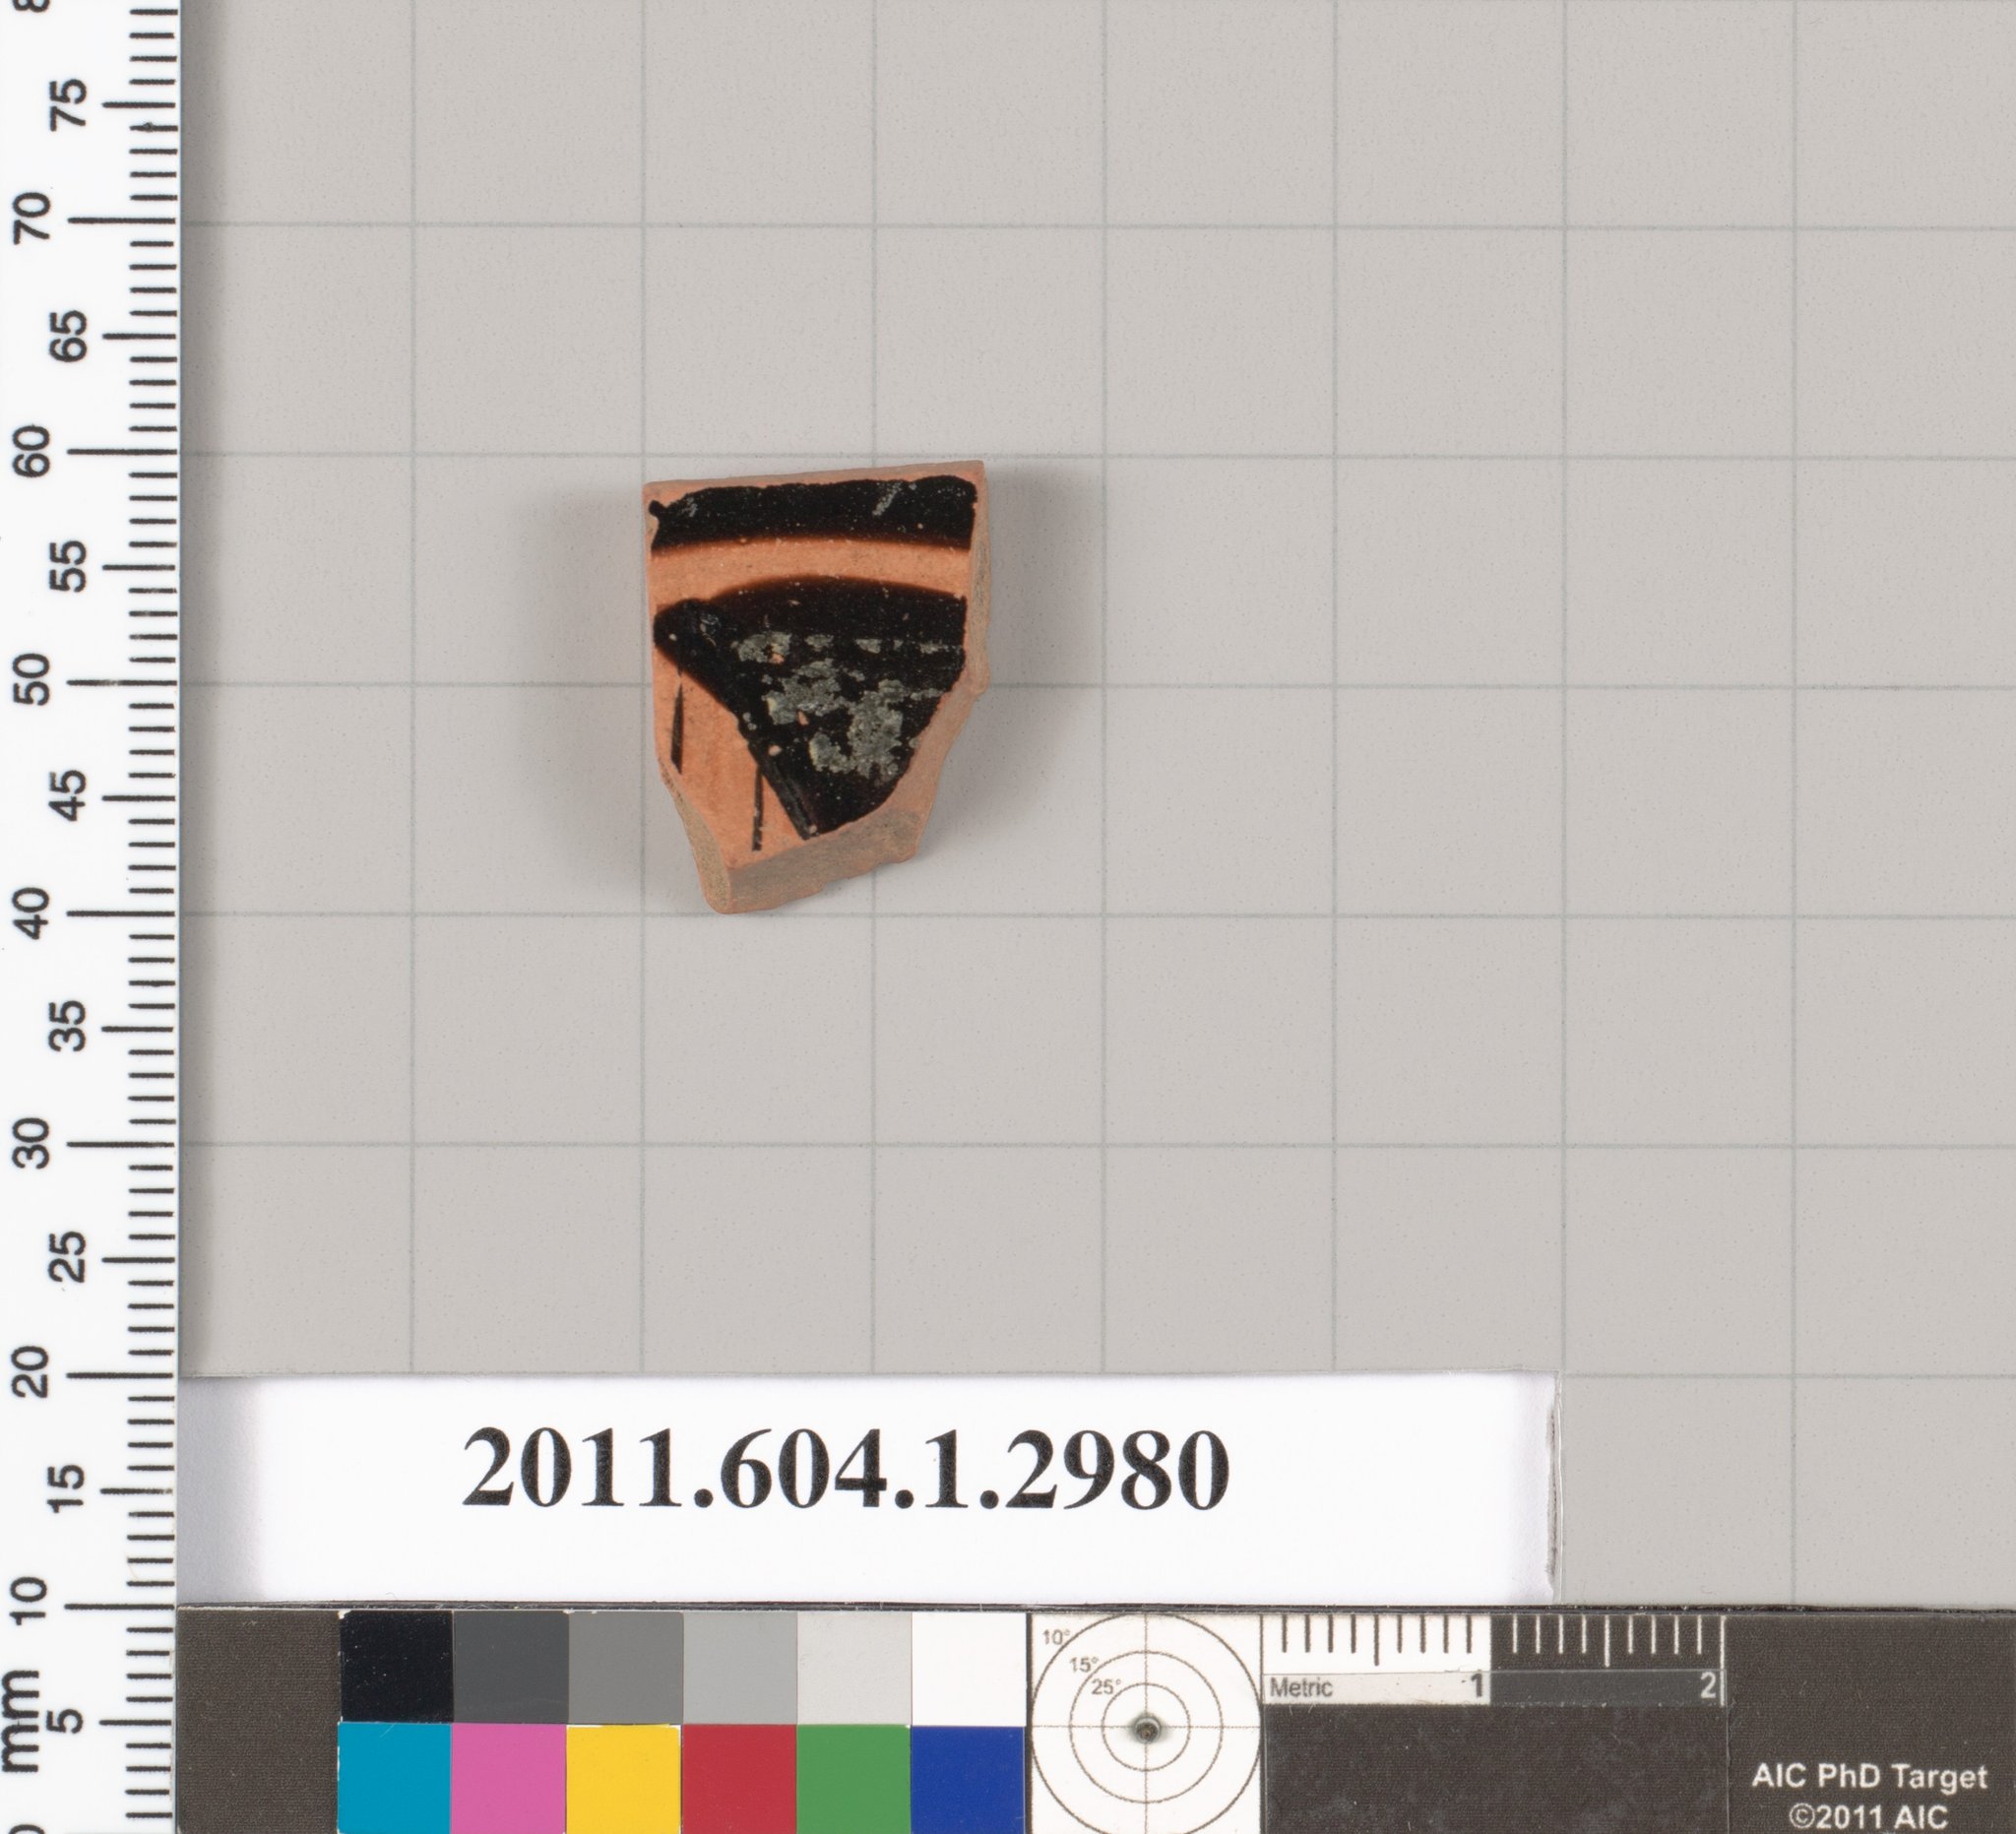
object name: kylix fragment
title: Terracotta fragment of a kylix (drinking cup)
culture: greek, attic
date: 475-451 BCE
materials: terracotta